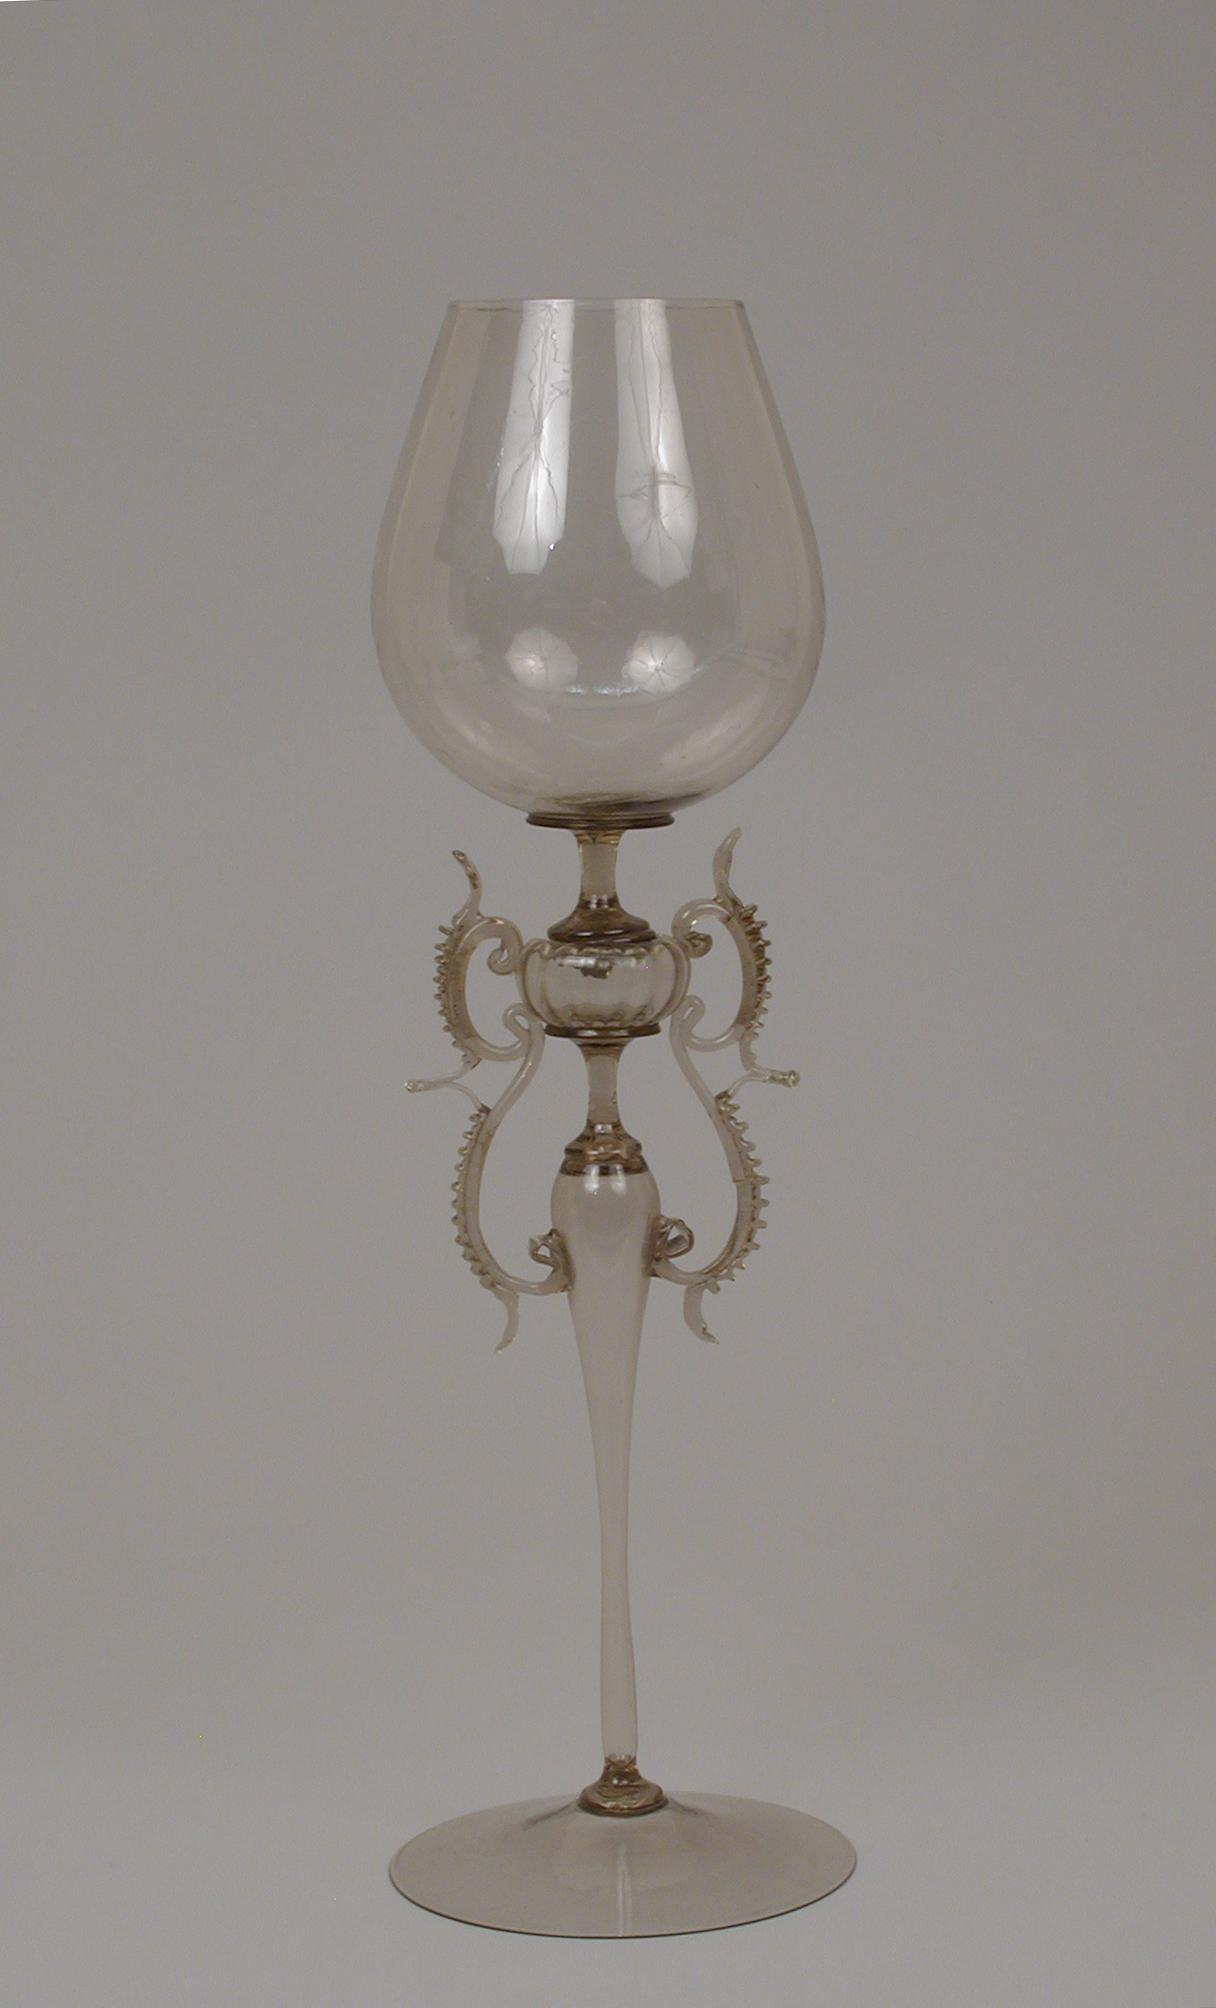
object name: goblet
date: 1801-1900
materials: glass